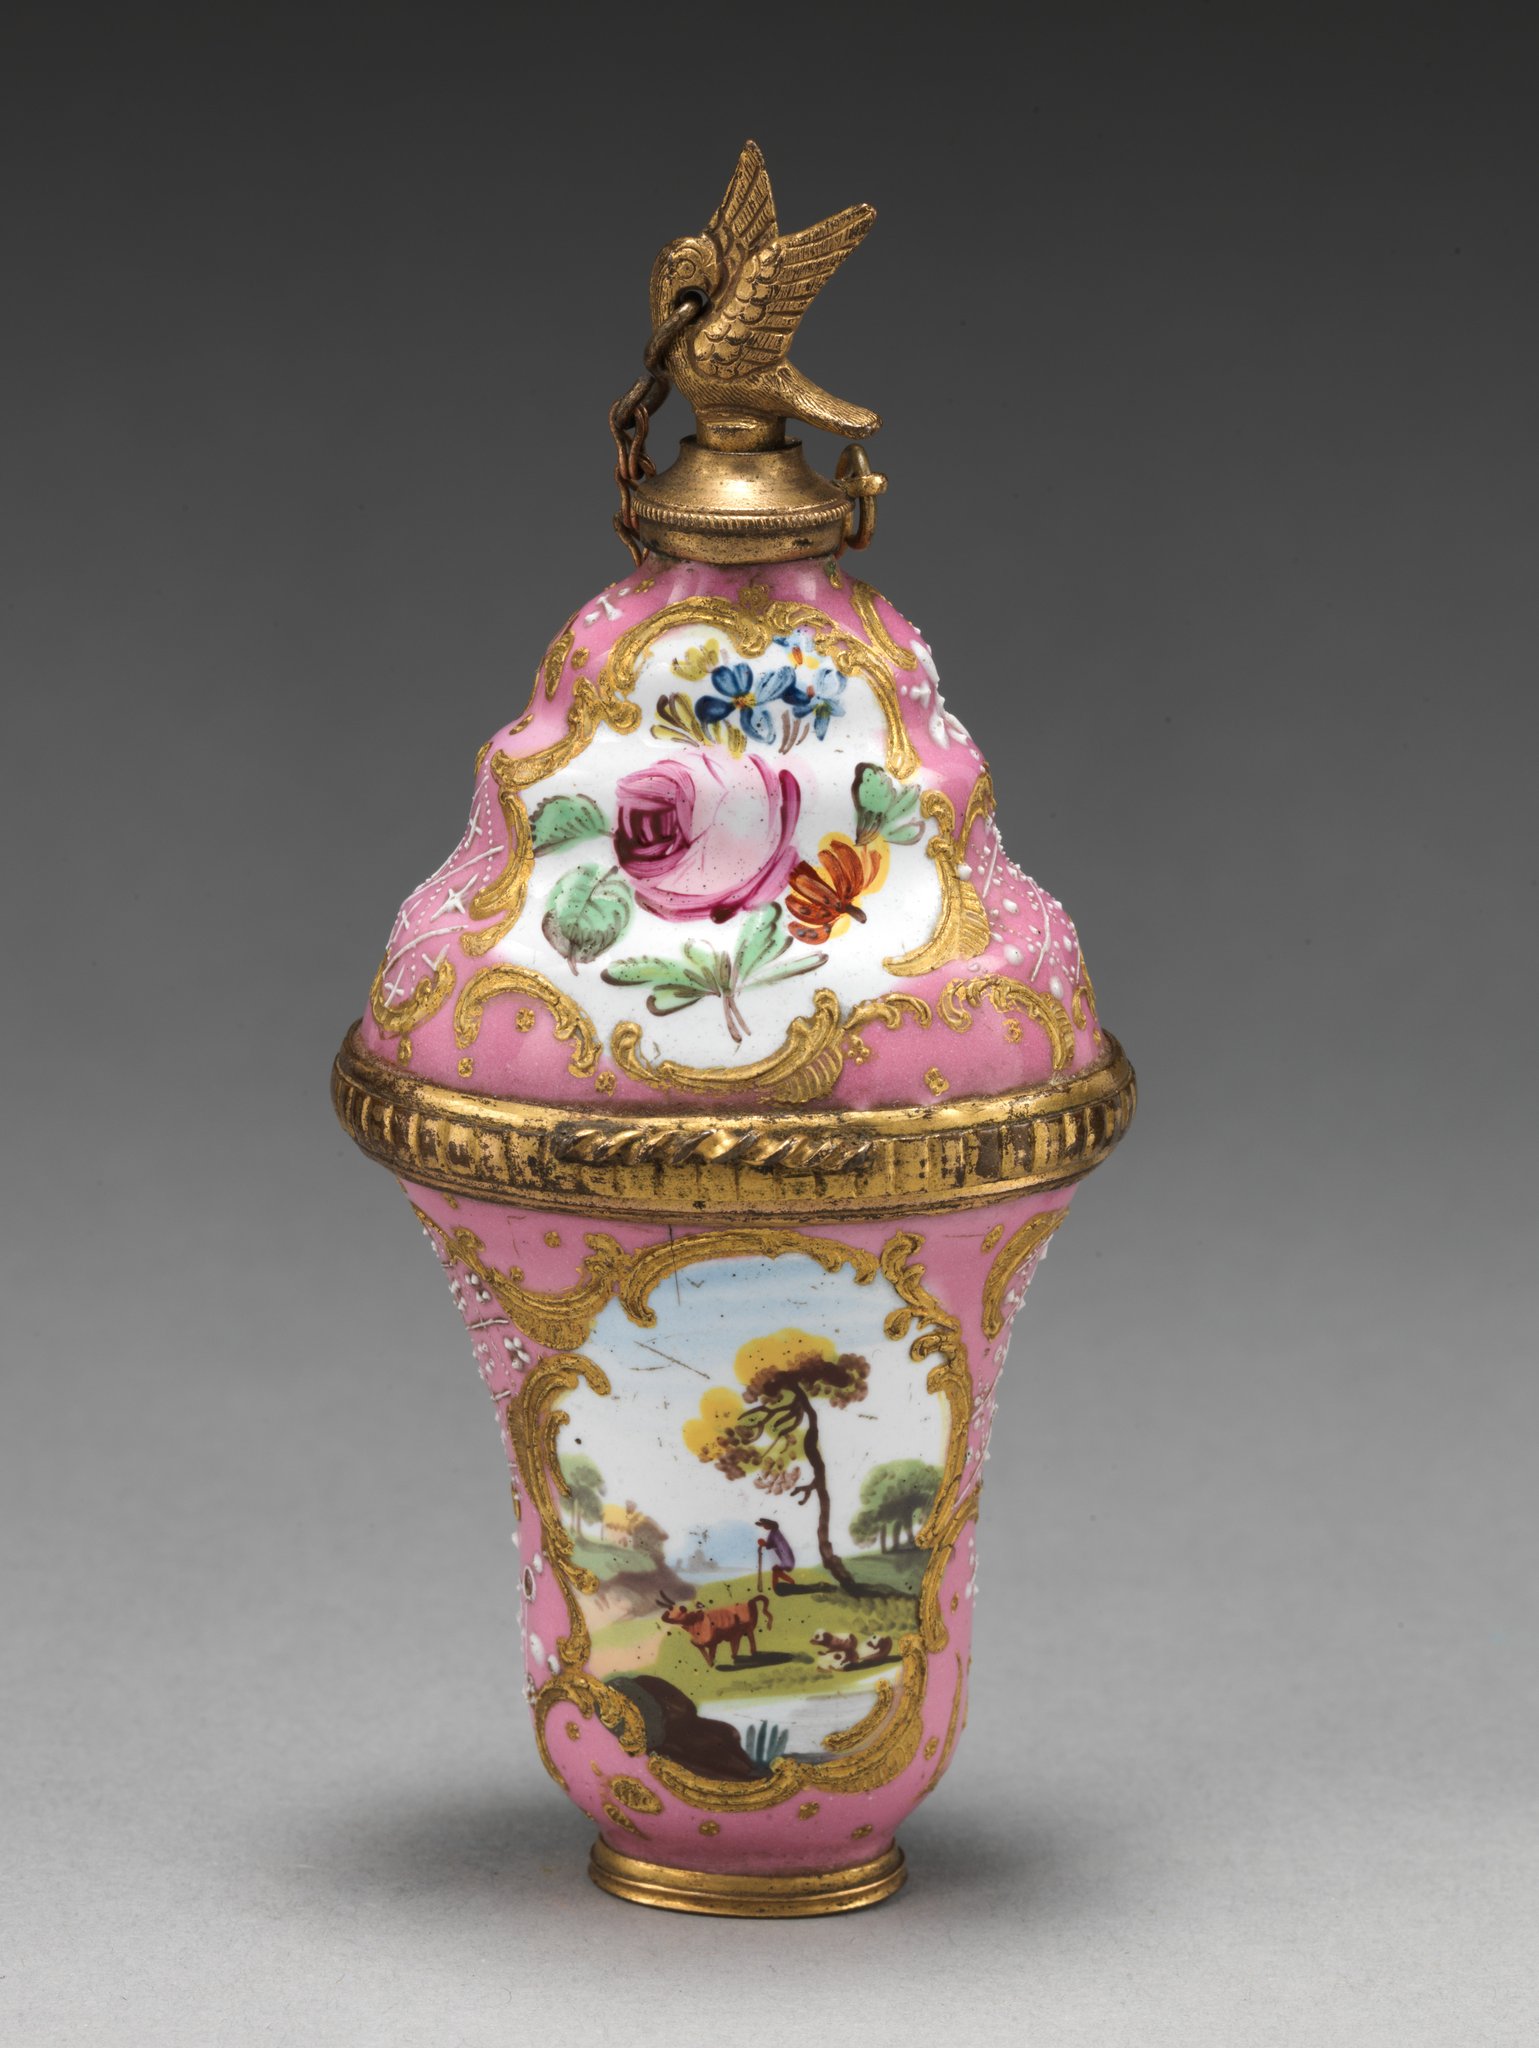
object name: scent bottle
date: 1765-1770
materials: copper, enamel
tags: animals,birds,flowers,trees